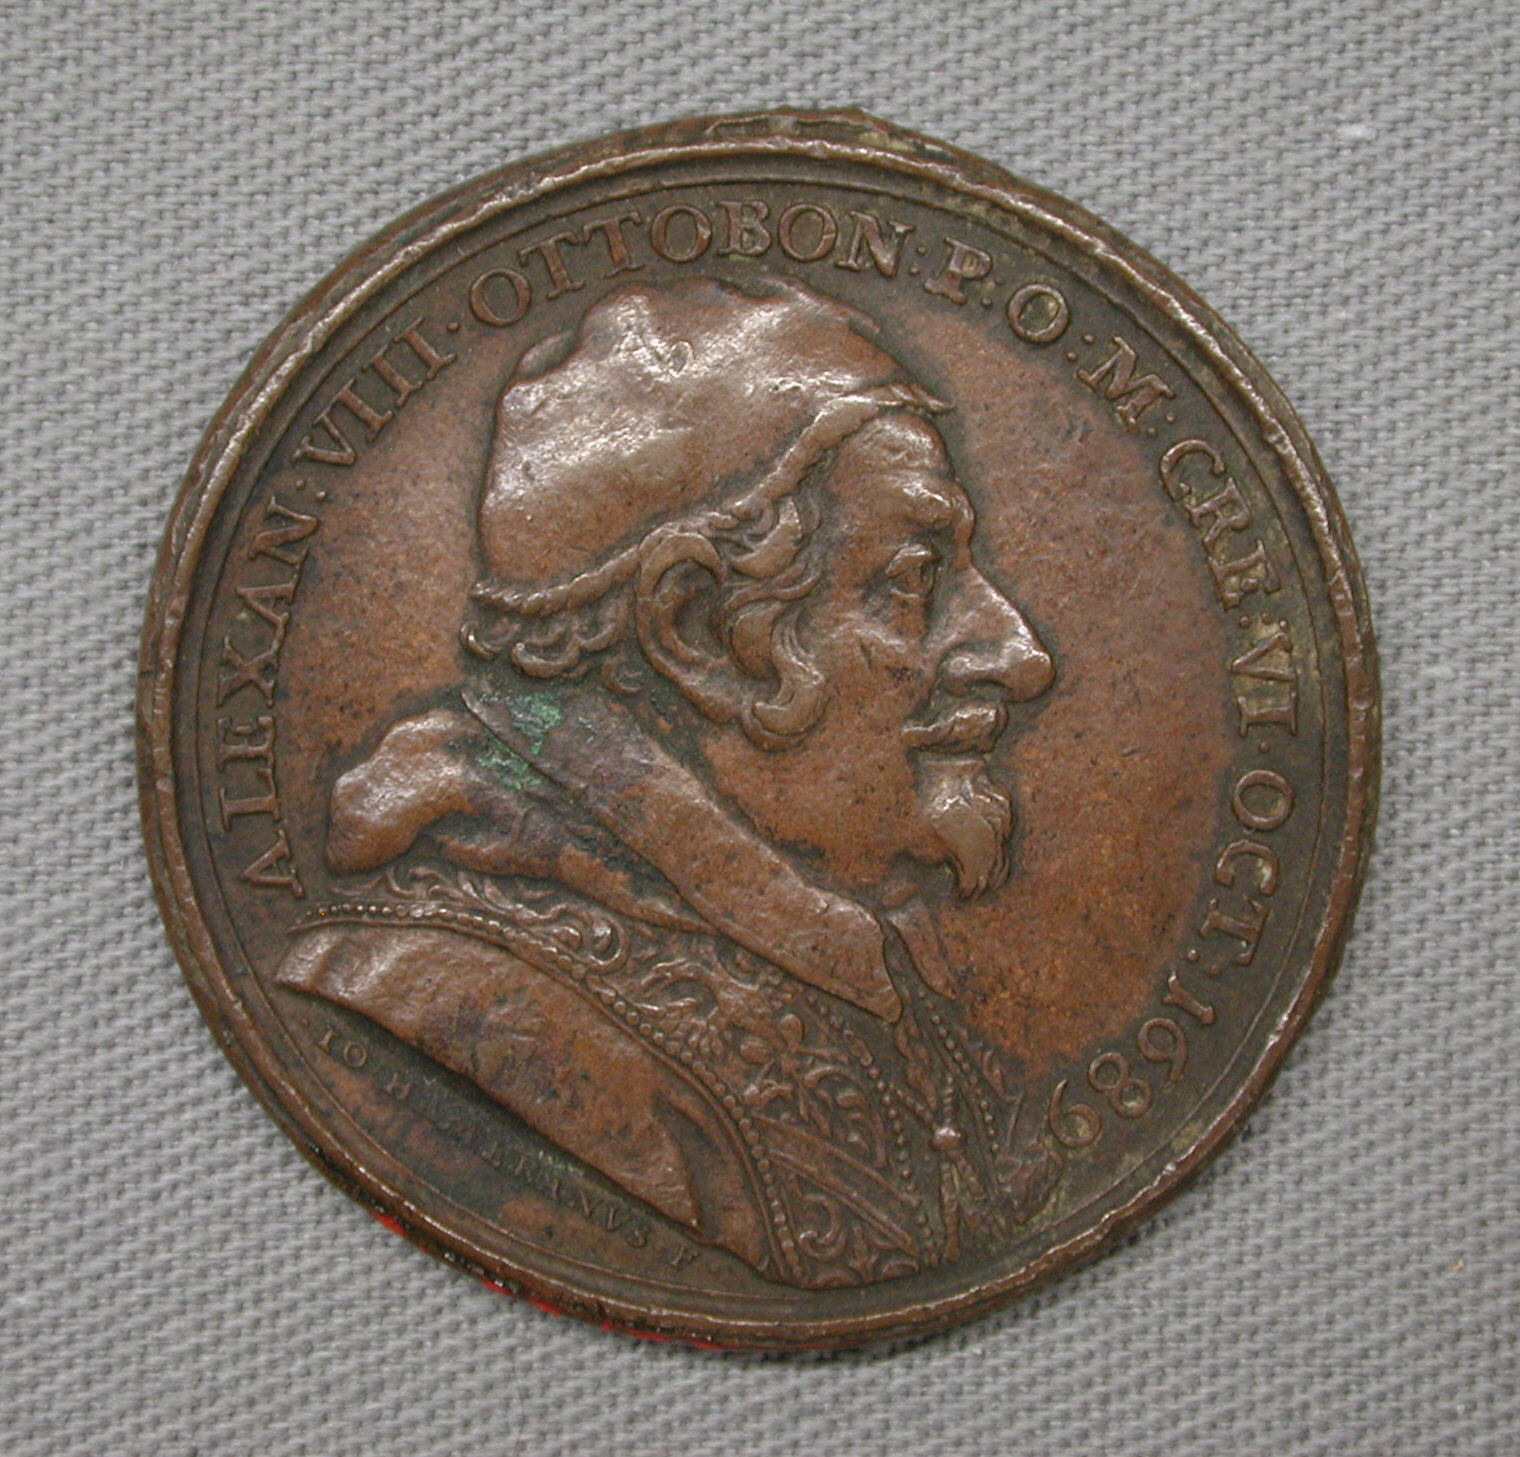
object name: medal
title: Pope Alexander VIII (1689–91)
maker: giovanni martino hamerani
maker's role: artist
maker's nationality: italian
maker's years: 1646-1705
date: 1601-1700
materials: bronze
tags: profiles,popes